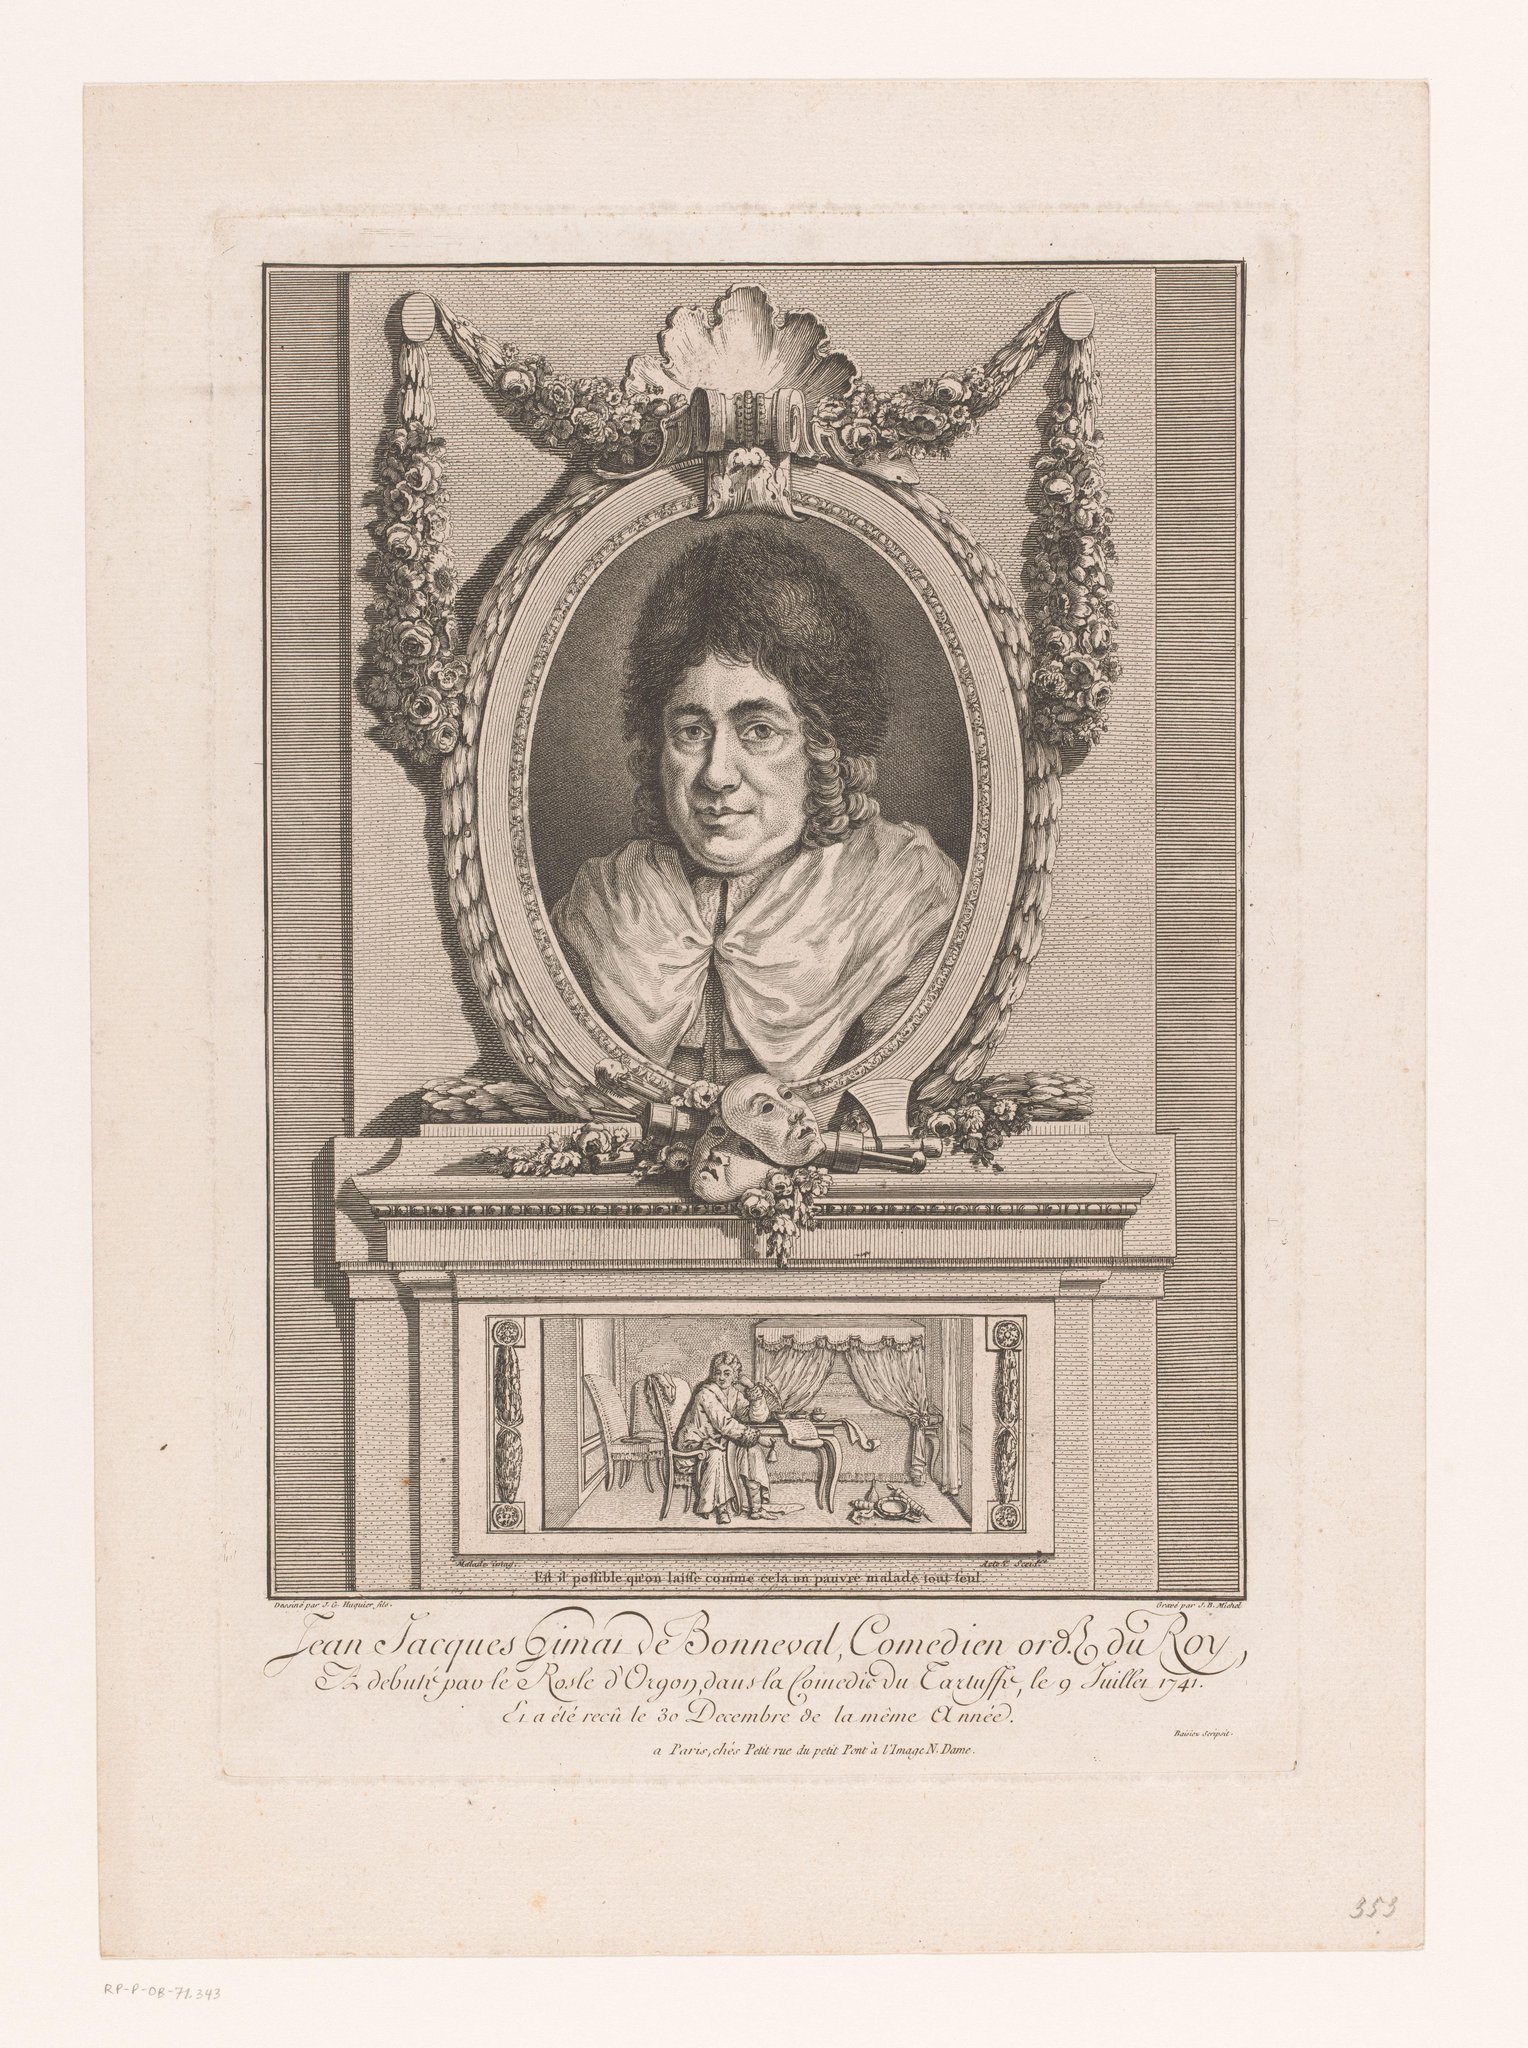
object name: print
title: Portret van Jean-Baptiste Jacques Gimat de Bonneval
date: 1758-1804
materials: paper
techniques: engraving, etching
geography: paris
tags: historical persons, portrait of a writer, portrait of actor, actress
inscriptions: collector's mark: Lugt 2228